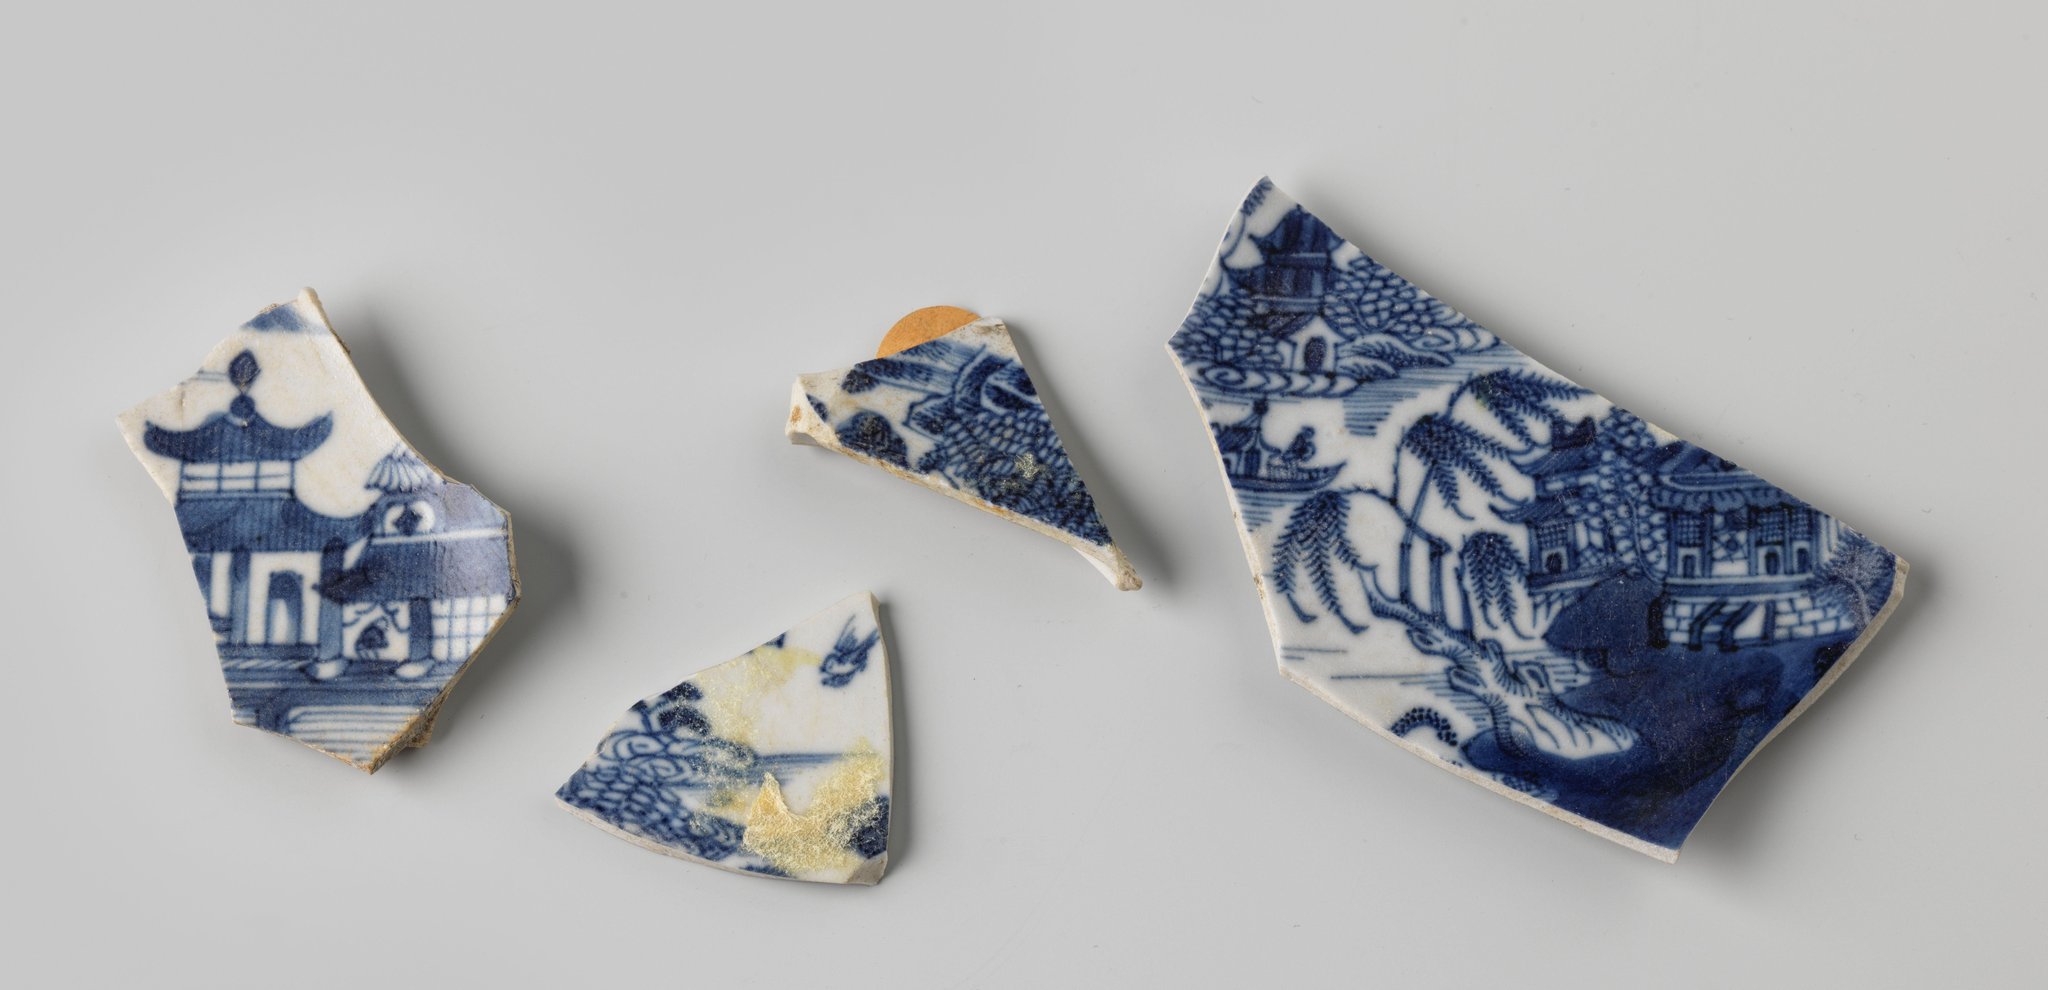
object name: plate dish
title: Vier porseleinen scherven van verschillende borden, gevonden bij V.O.C.-schip Witte Leeuw, mogelijk afkomstig van Zeelelie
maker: Anonymous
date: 1775-1800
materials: porcelain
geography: jingdezhen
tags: verenigde oostindische compagnie, sint-helena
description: Vier porseleinen scherven van verschillende borden gevonden bij V.O.C.-schip de 'Witte Leeuw'. Dit object is 18e-eeuws en kan dus niet van de vracht van de Witte Leeuw zijn. Onduidelijk is of het object van de site komt of dat het later is vermengd, mogelijk met materiaal van de Zeelelie.